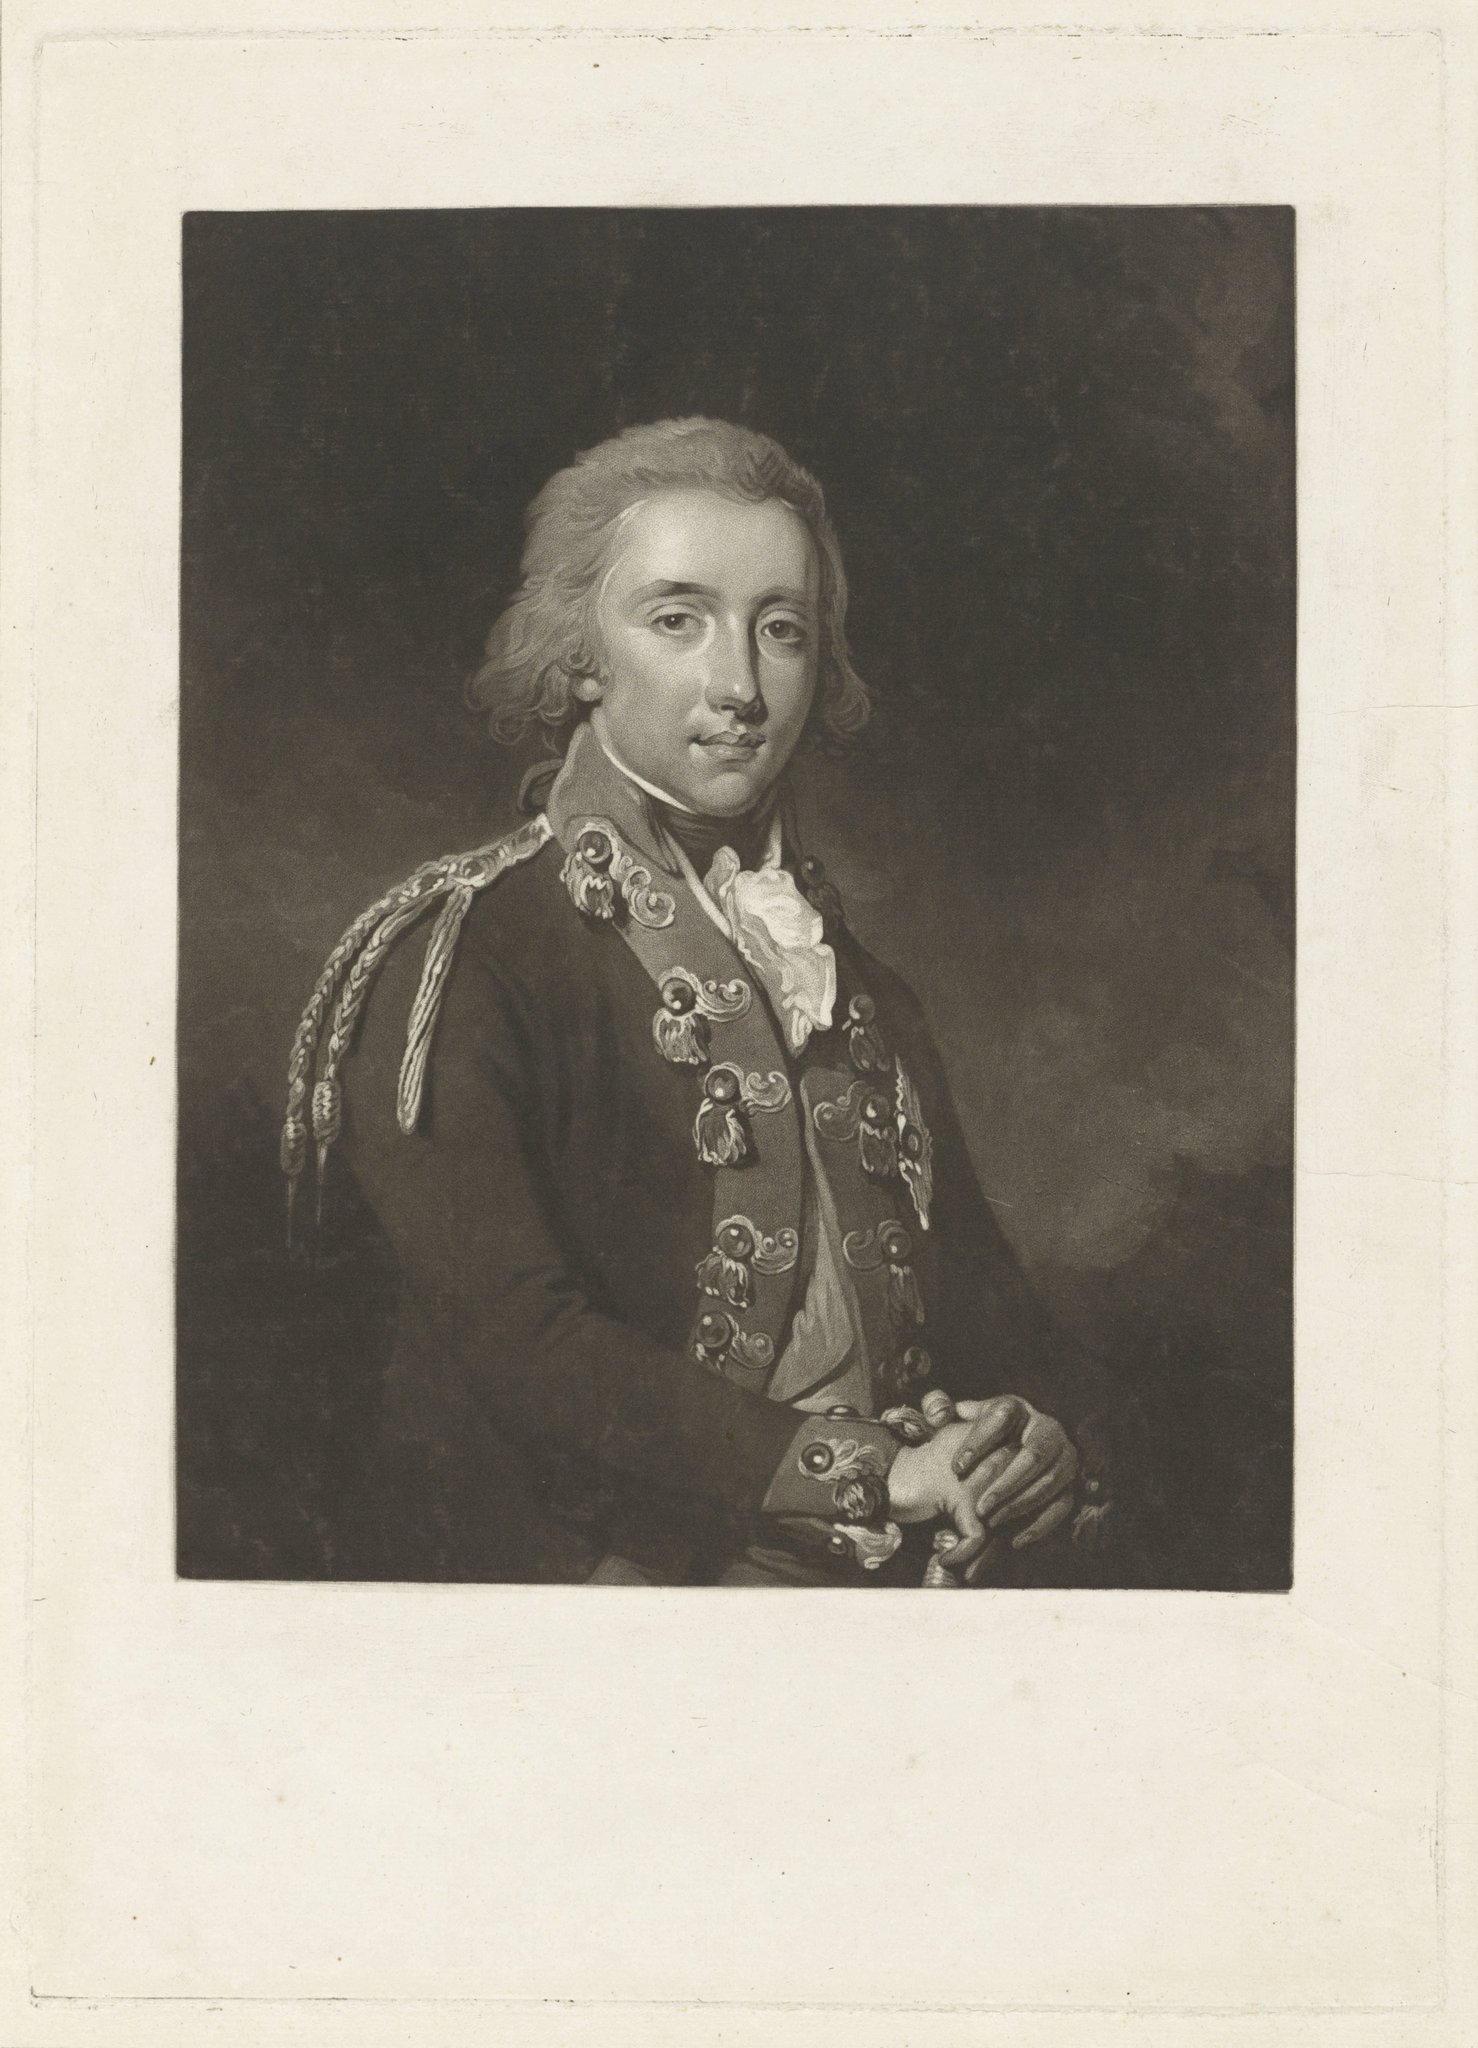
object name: print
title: Portret van Willem George Frederik, prins van Oranje-Nassau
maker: charles howard hodges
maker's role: draughtsman, painter, print maker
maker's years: 1764-1837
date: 1794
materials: paper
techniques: mezzotint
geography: netherlands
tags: willem george frederik (prins van oranje-nassau)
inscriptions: :, collector's mark: Lugt 2228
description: Willem George Frederik, prins van Oranje-Nassau gekleed in een uniform, met de handen over elkaar.